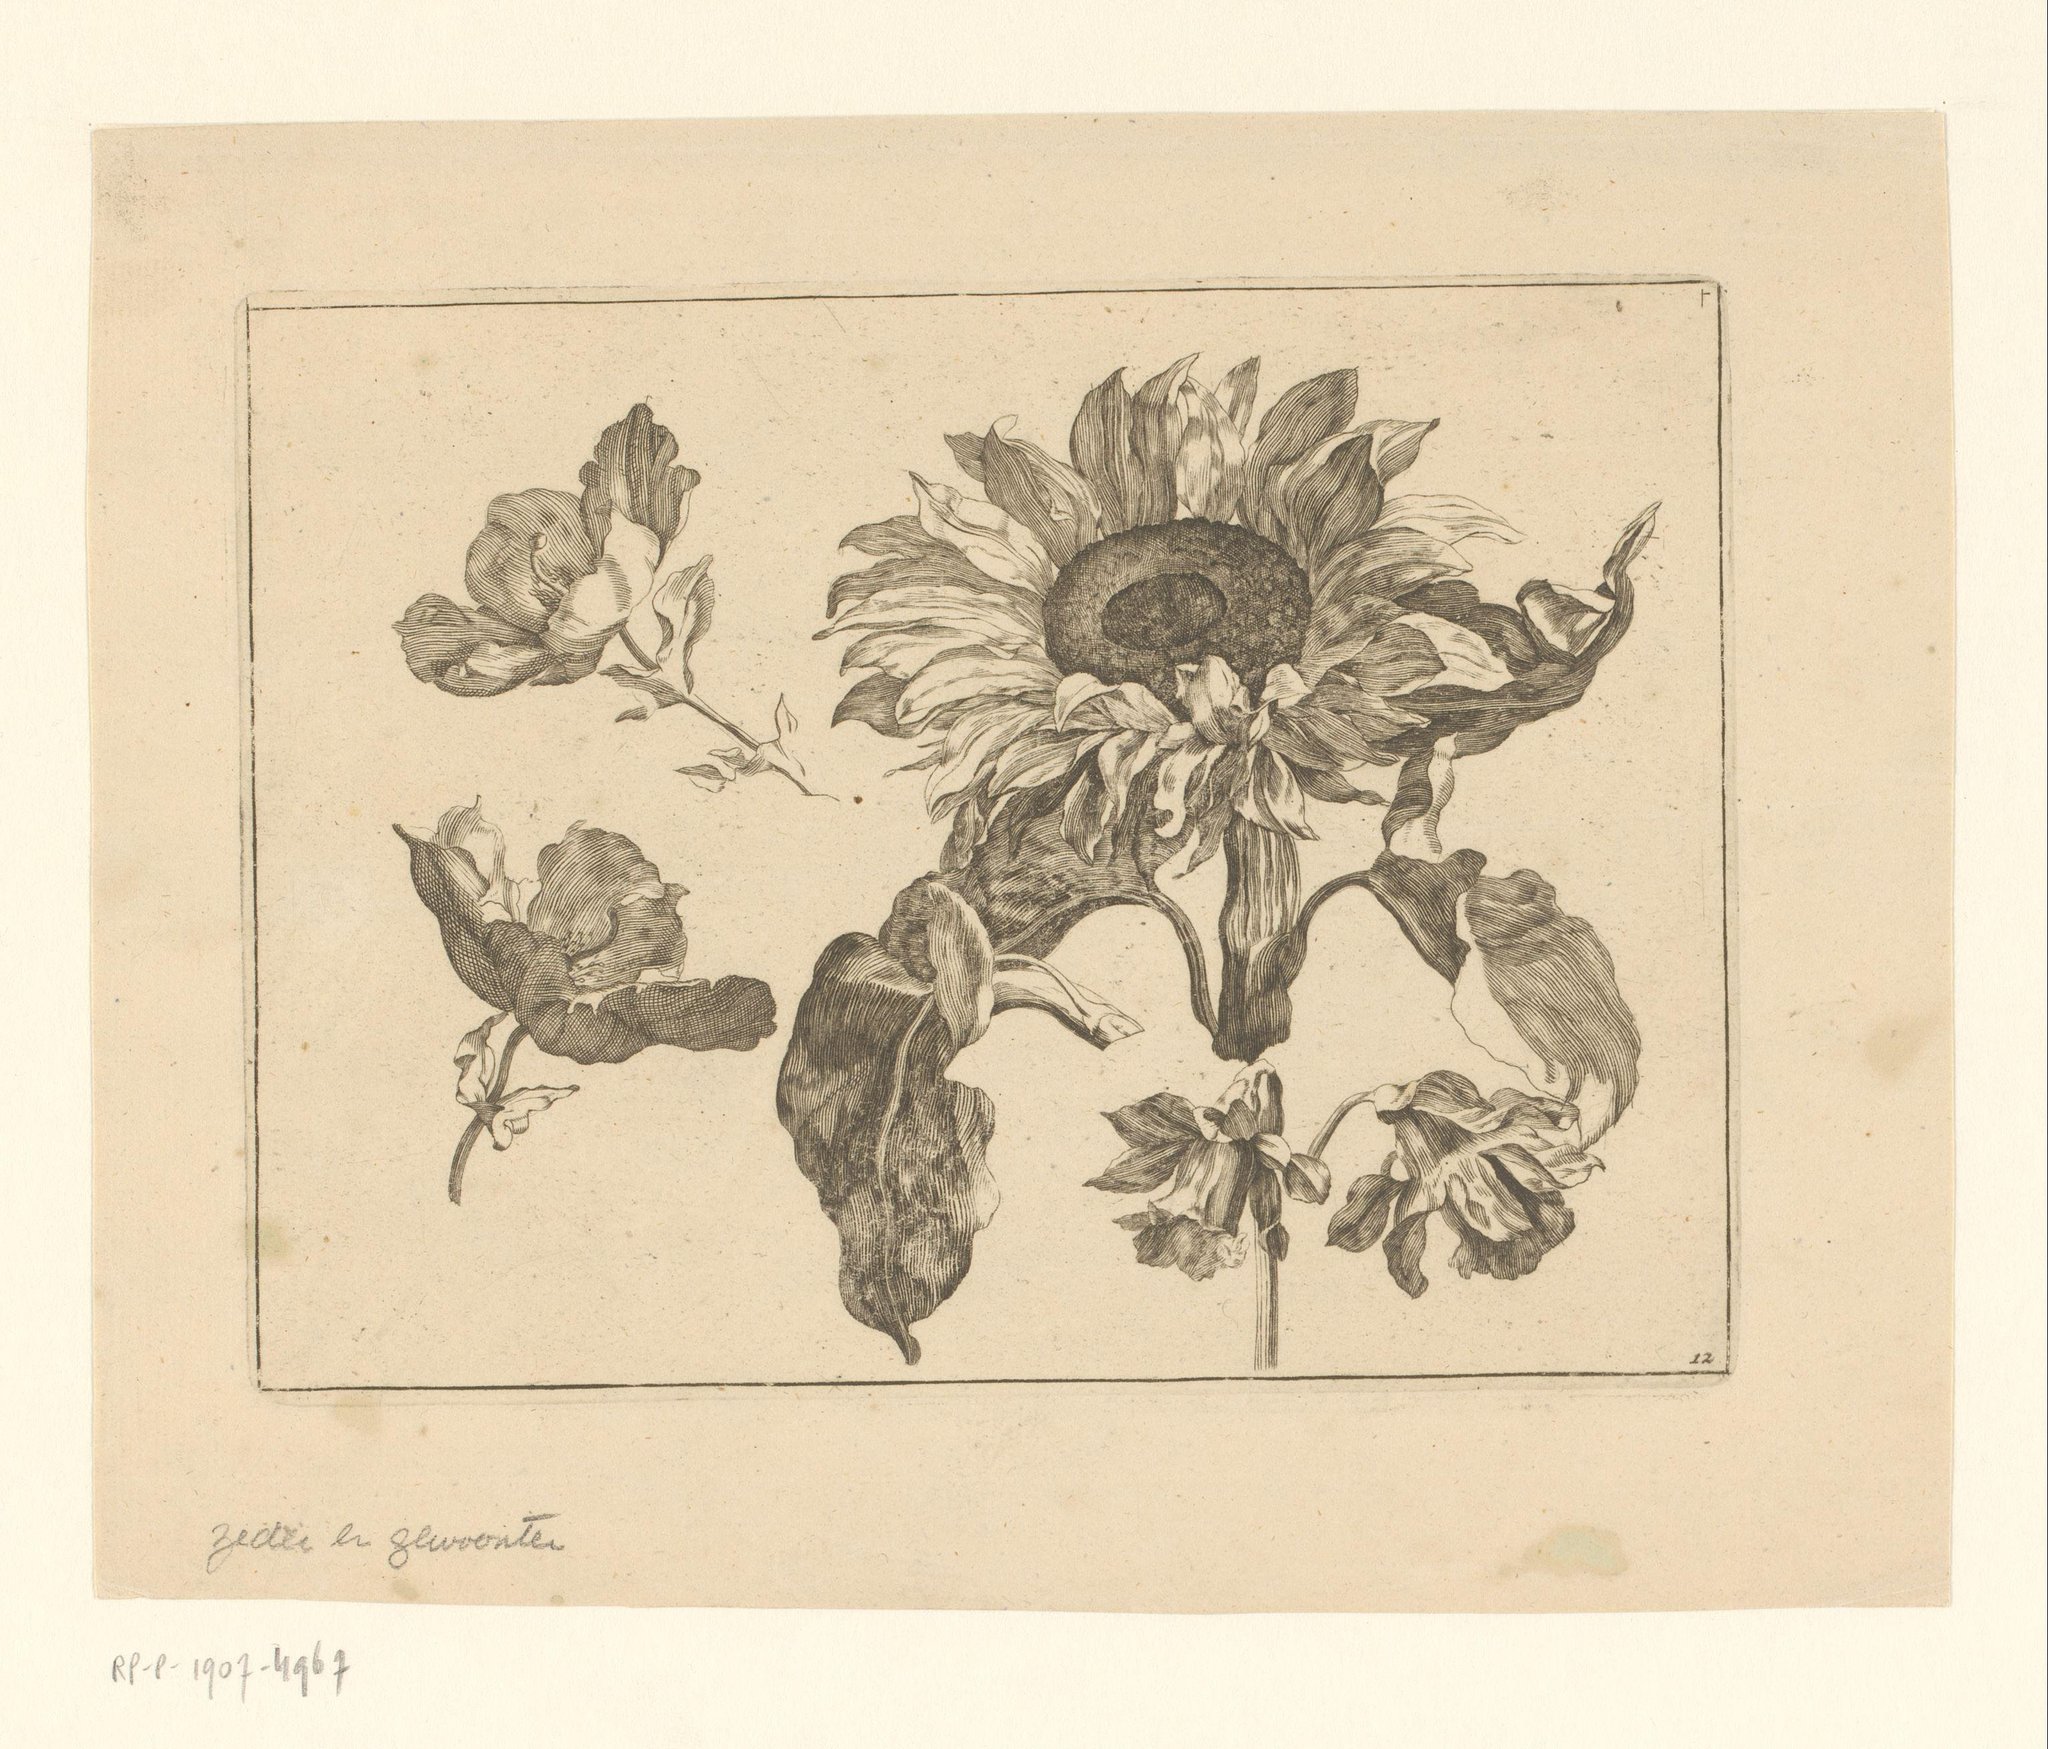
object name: print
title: Studie van zonnebloem, narcis en lelies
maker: Anonymous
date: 1680-1730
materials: paper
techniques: engraving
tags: flowers: sunflower, flowers: lily, flowers: narcissus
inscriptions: collector's mark: Lugt 2228